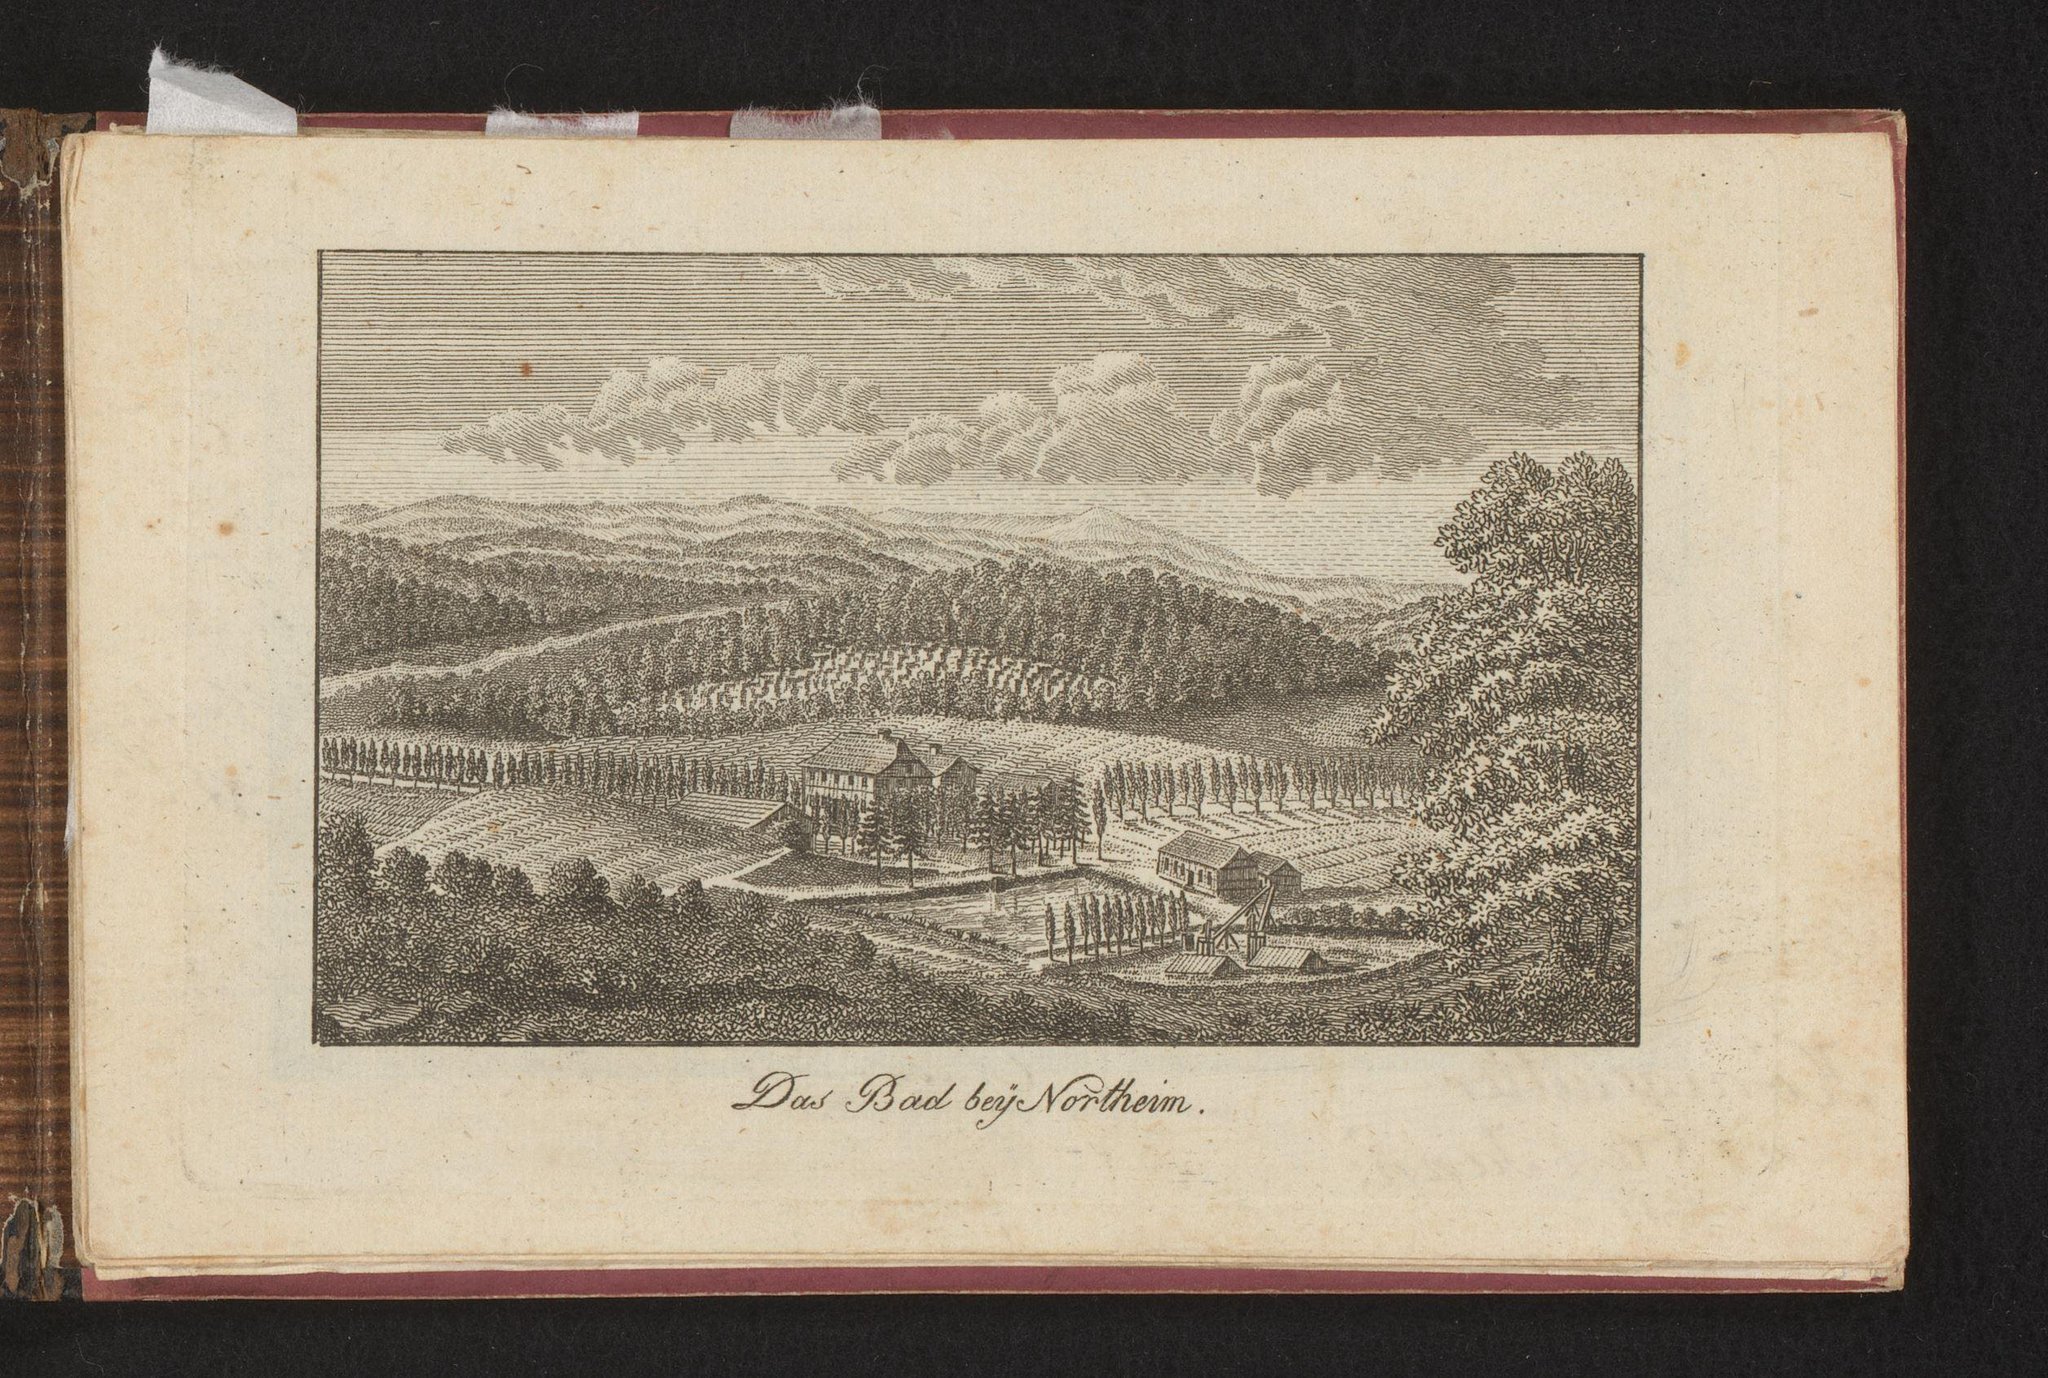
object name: print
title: Das Bad beij Northeim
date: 1770-1817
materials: ink, paper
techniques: etching, writing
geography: gottingen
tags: 'album amicorum', 'stammbuch'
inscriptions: tekst, verso, handgeschreven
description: Handgeschreven tekst in het Duits op het verso.